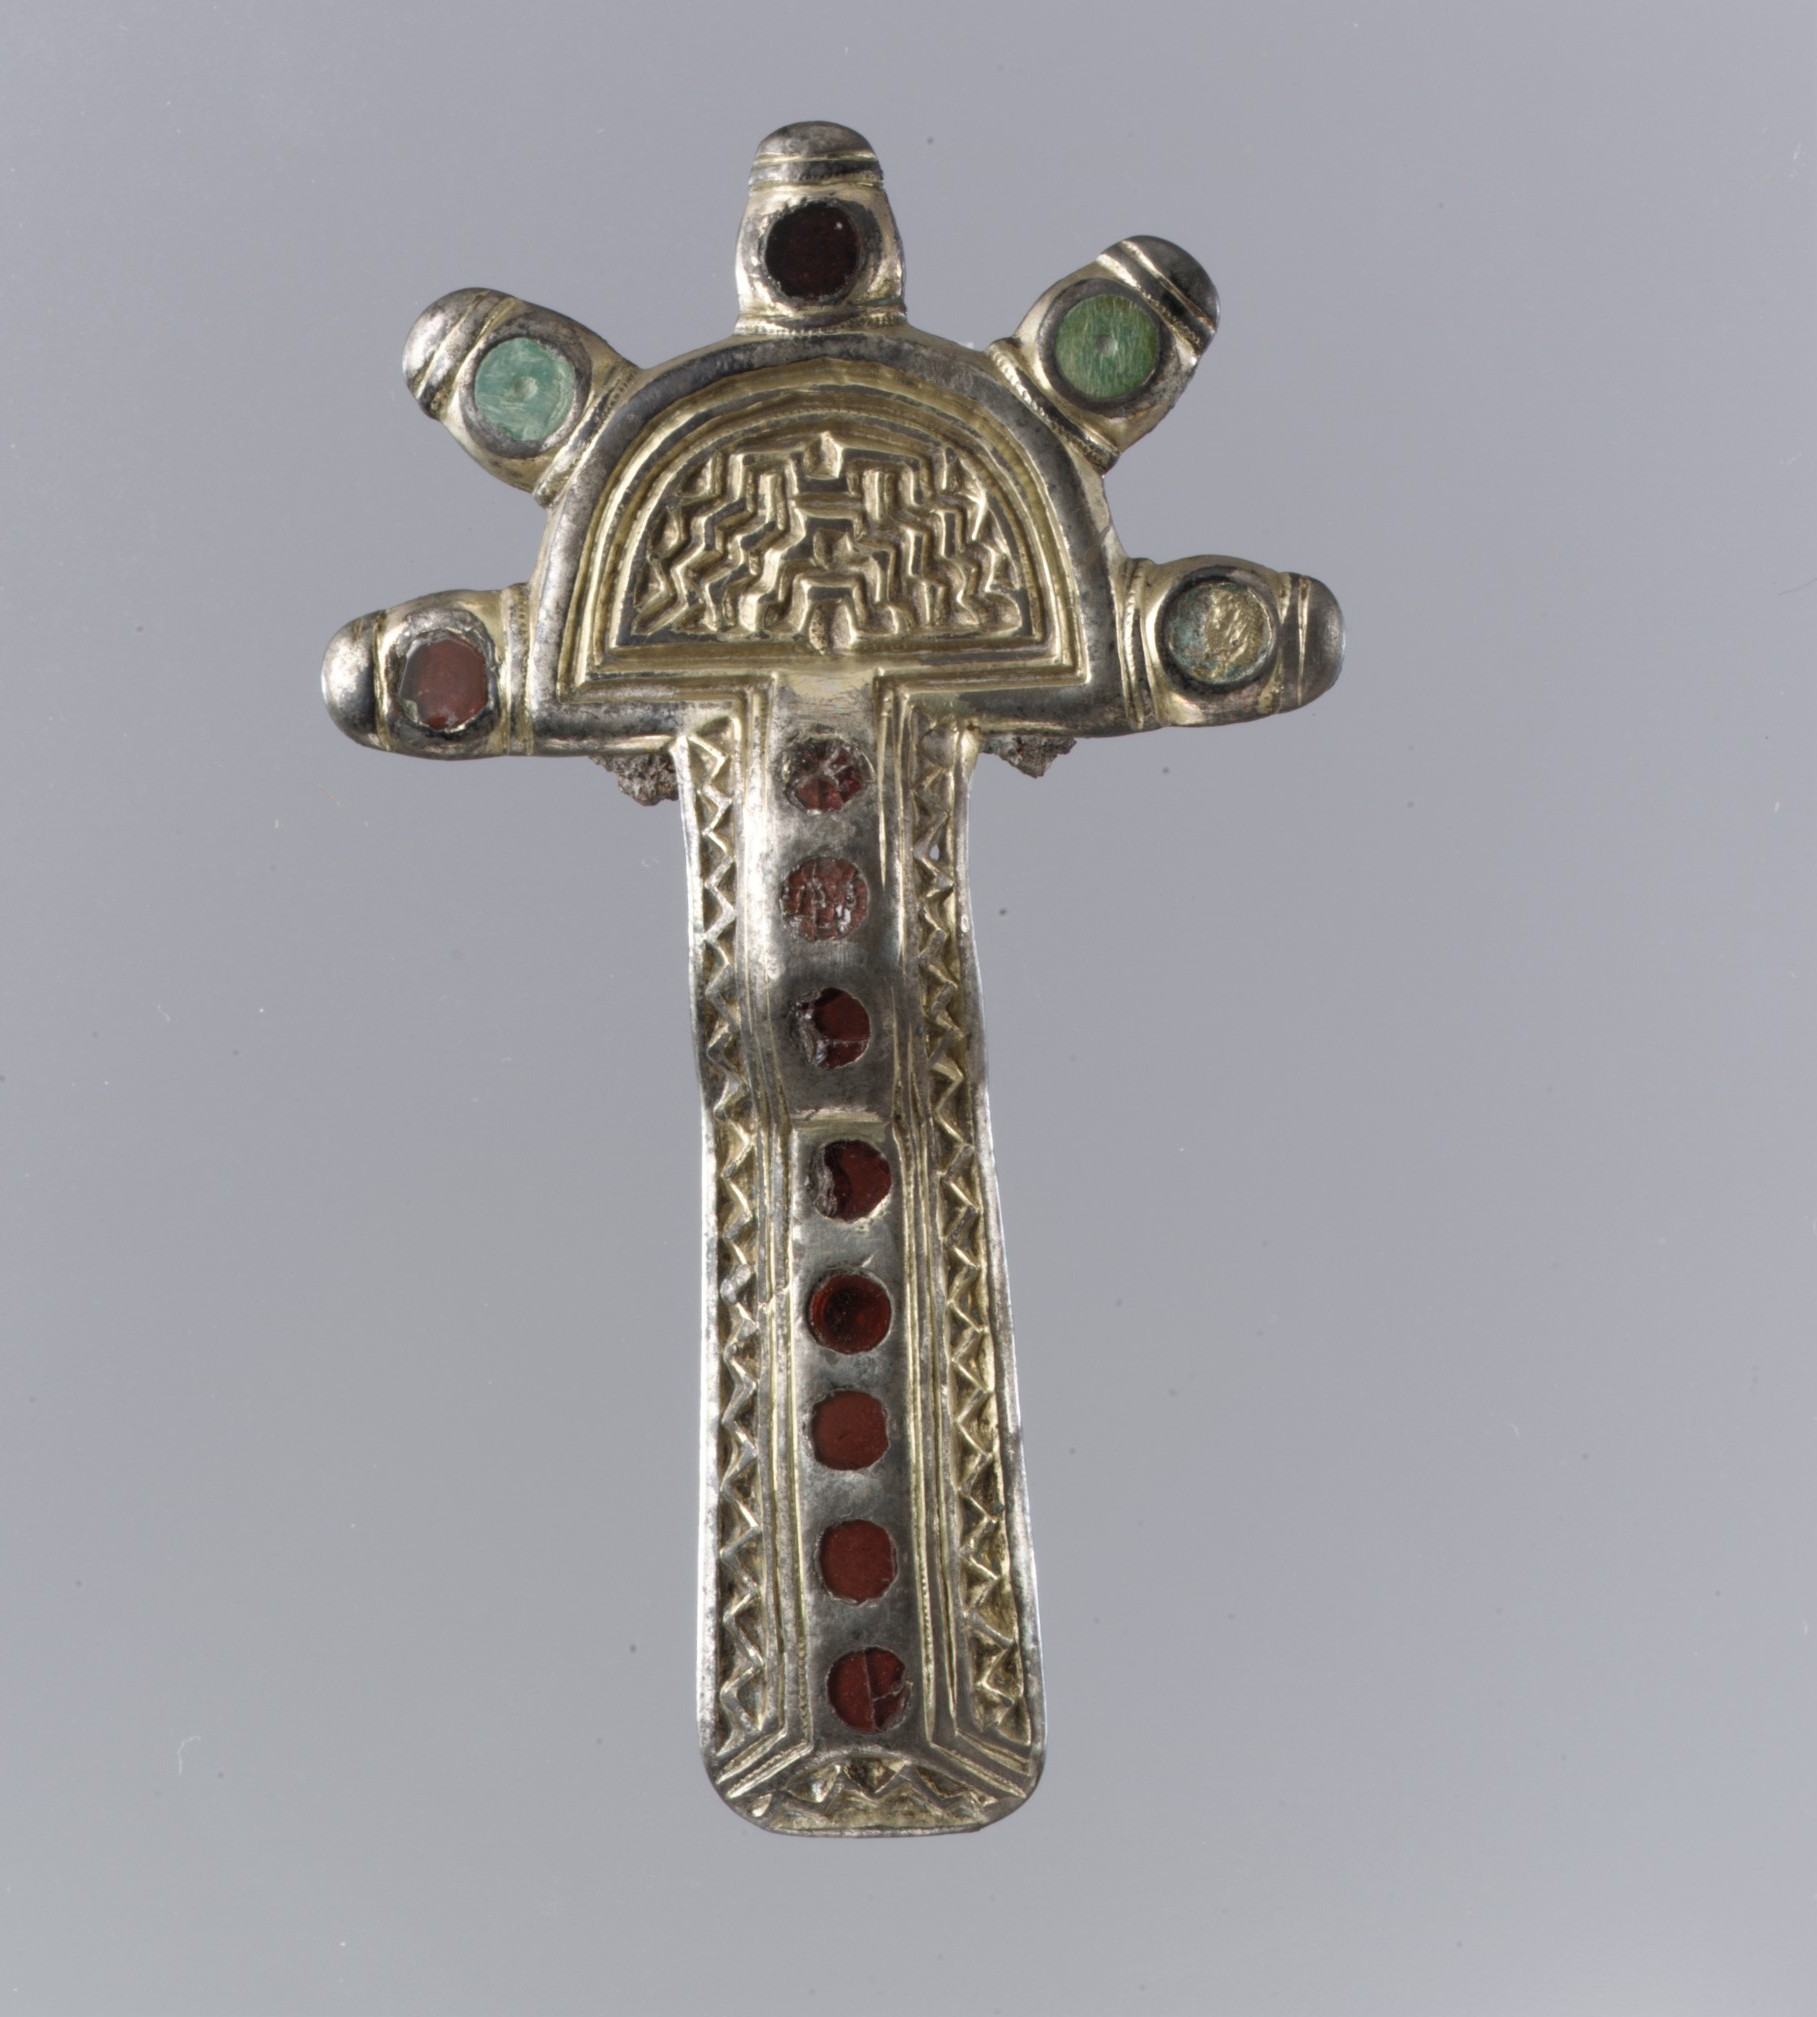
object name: brooch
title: Bow Brooch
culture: frankish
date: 500-550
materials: bone, foil, gemstone, gilt, iron, silver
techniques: casting